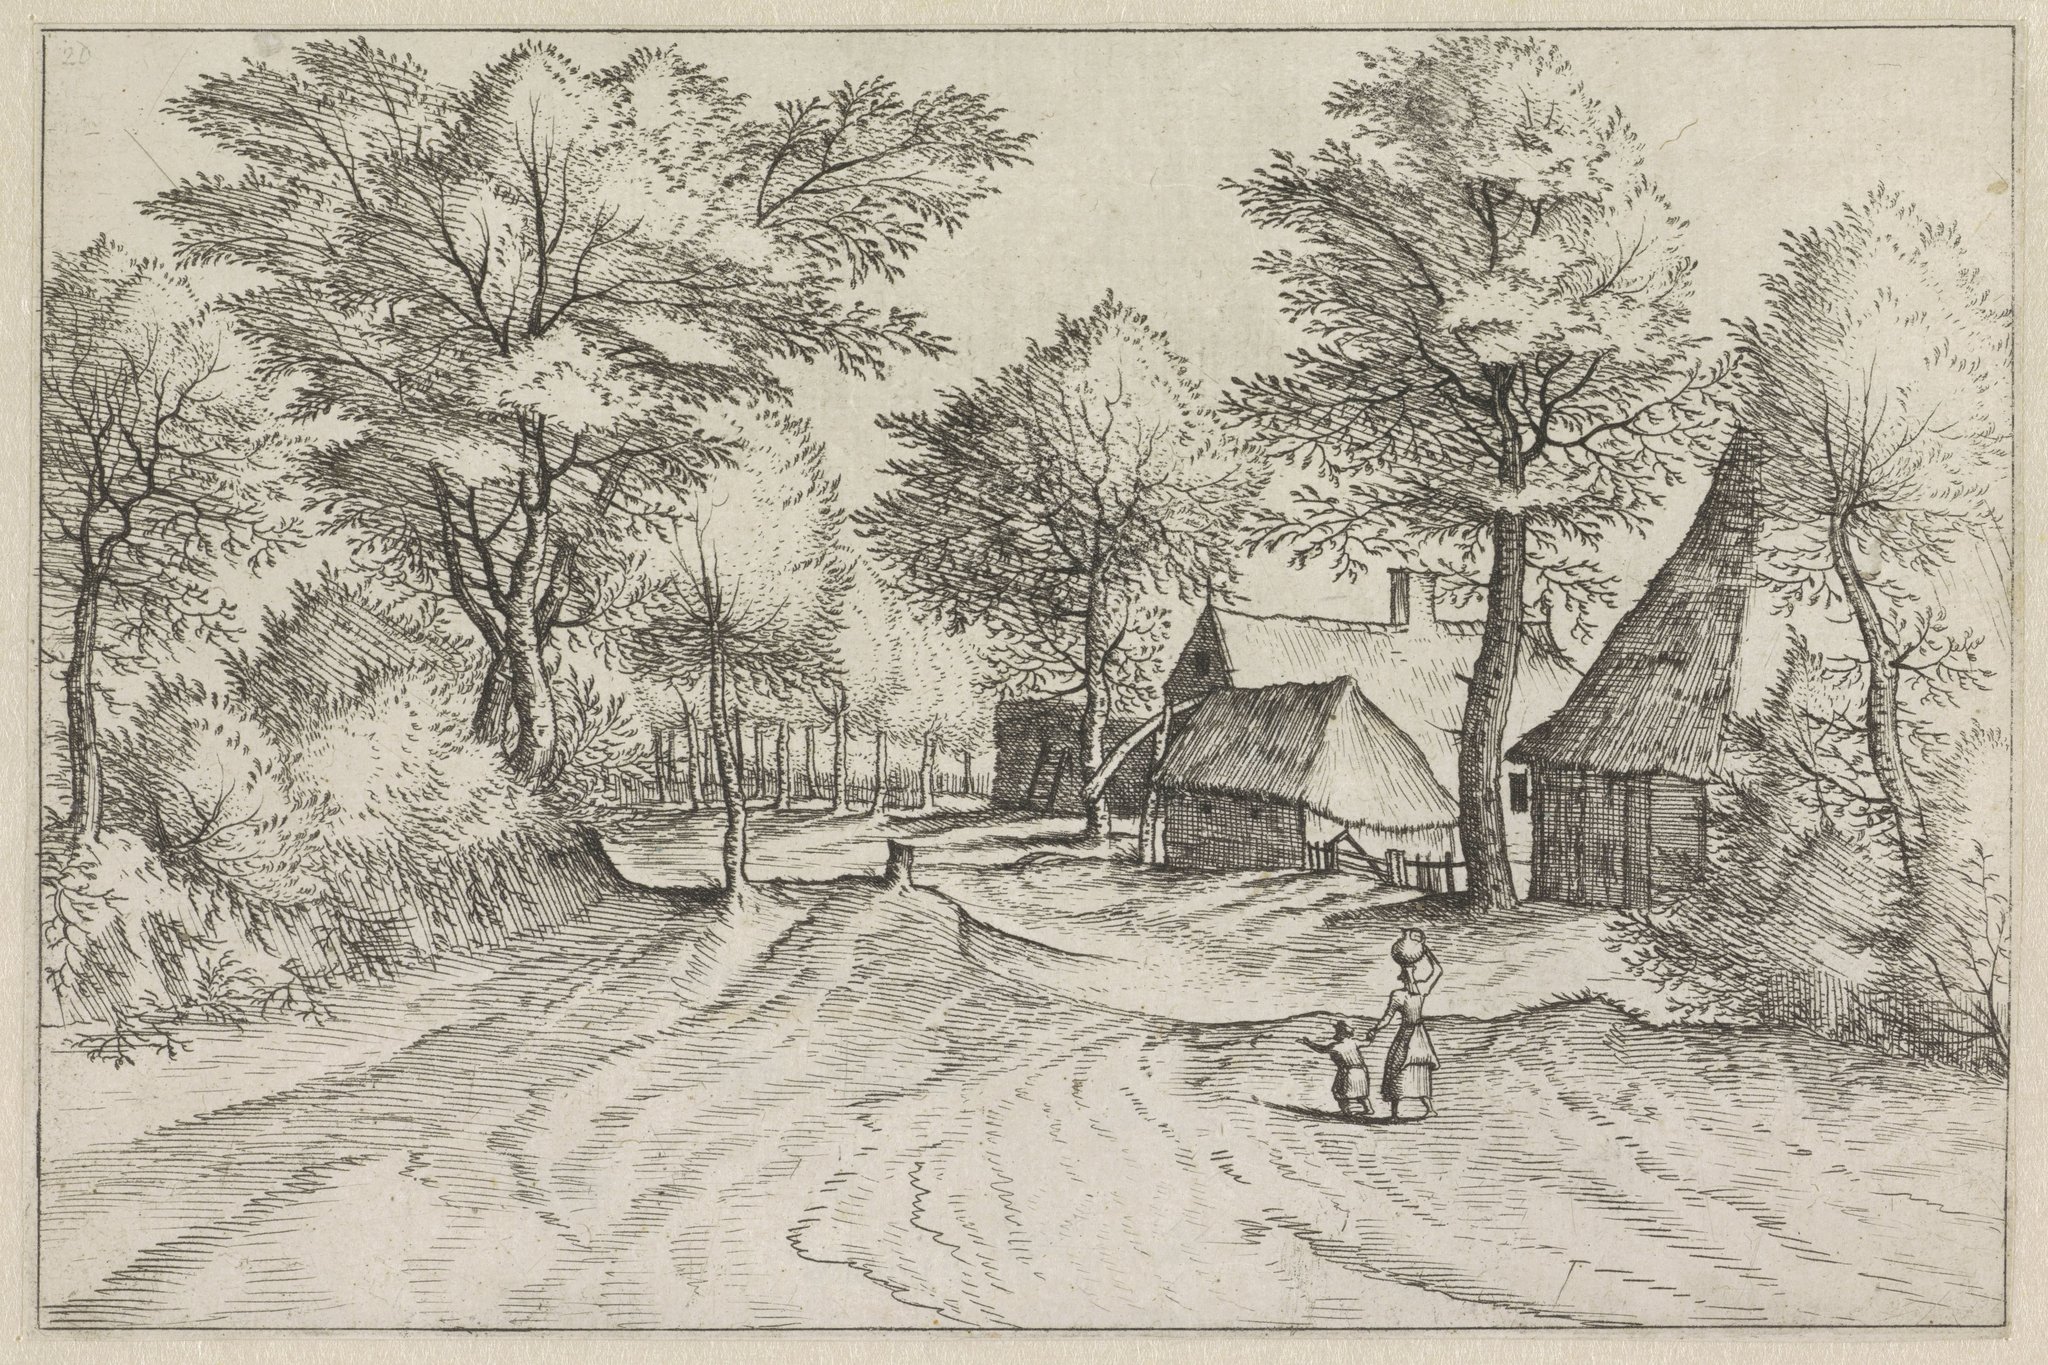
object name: print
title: Kleine landschappen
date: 1559-1561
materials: paper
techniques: etching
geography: antwerp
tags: public road in village, farm (building)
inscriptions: collector's mark: Lugt 2228, collector's mark: Lugt 2760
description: Gezicht op een dorpsweg met rechts een boerderij en schuren. Op de weg een vrouw met een kruik op haar hoofd en een kind aan de hand.